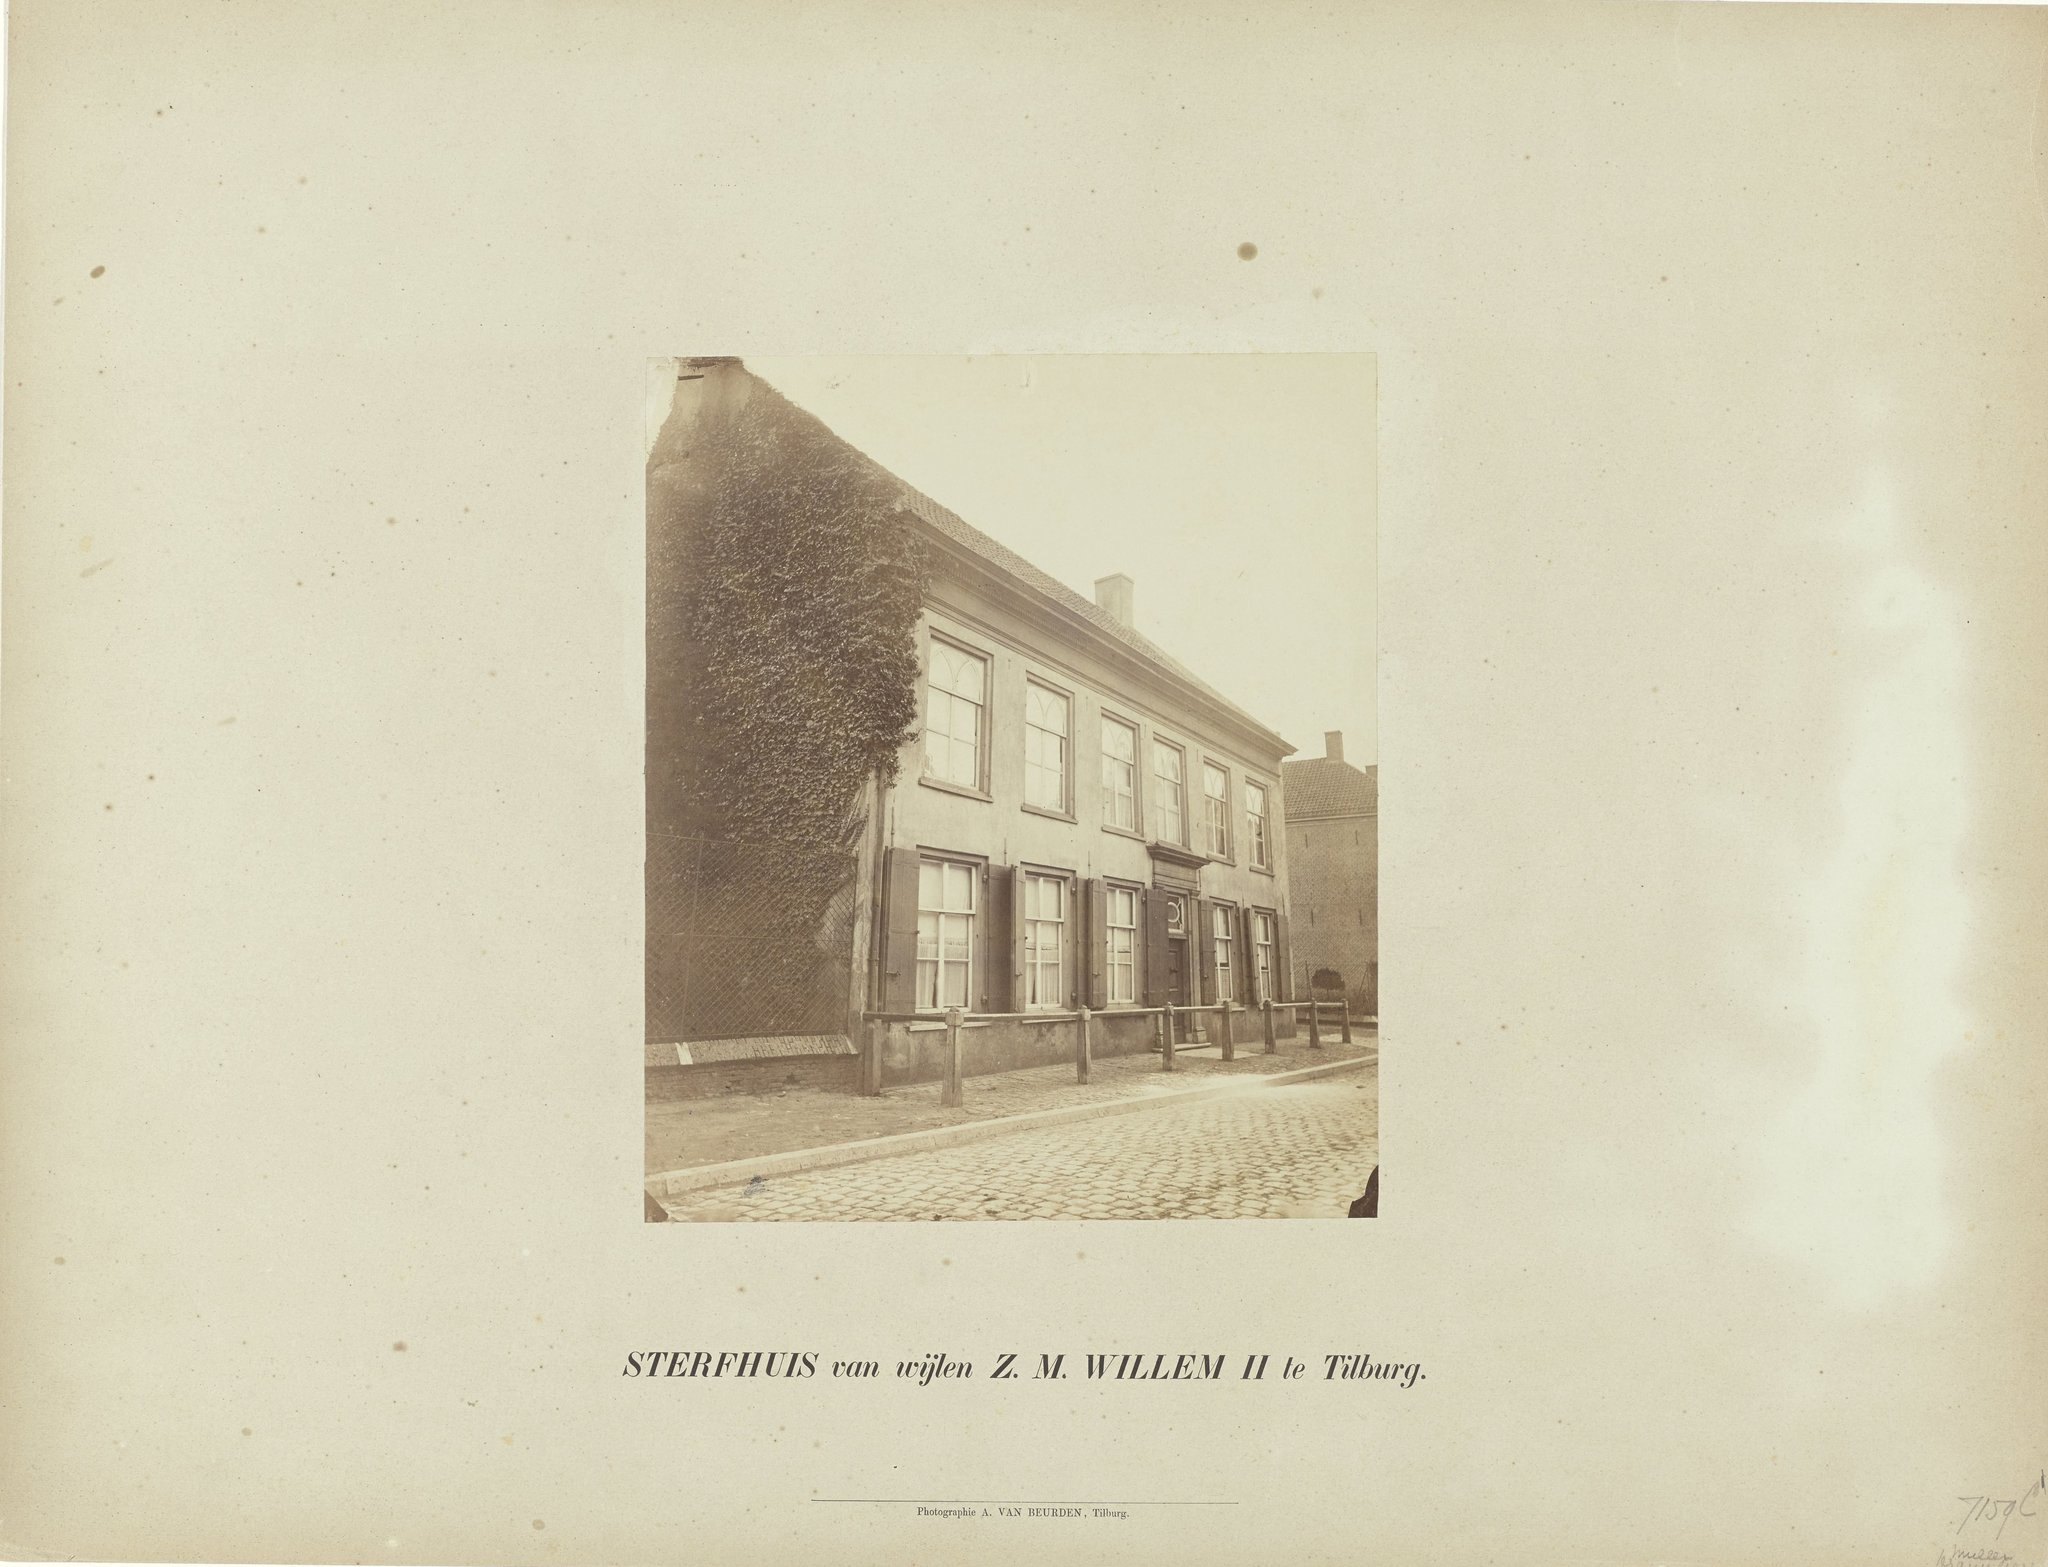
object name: photograph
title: Sterfhuis van wijlen Z.M. Willem II te Tilburg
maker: adrianus van beurden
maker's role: fotograaf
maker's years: 1843-1915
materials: cardboard, paper, photographic support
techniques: albumen print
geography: tilburg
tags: the hague, william ii of the netherlands, urban housing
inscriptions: collector's mark: Lugt 2233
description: Gezicht op het huis in Tilburg waar koning Willem II is overleden op 17 maart 1849. Herenhuis destijds gelegen aan het tegenwoordige Stadhuisplein. Het gebouw is in 1873 gesloopt. Zie ook de pendant.